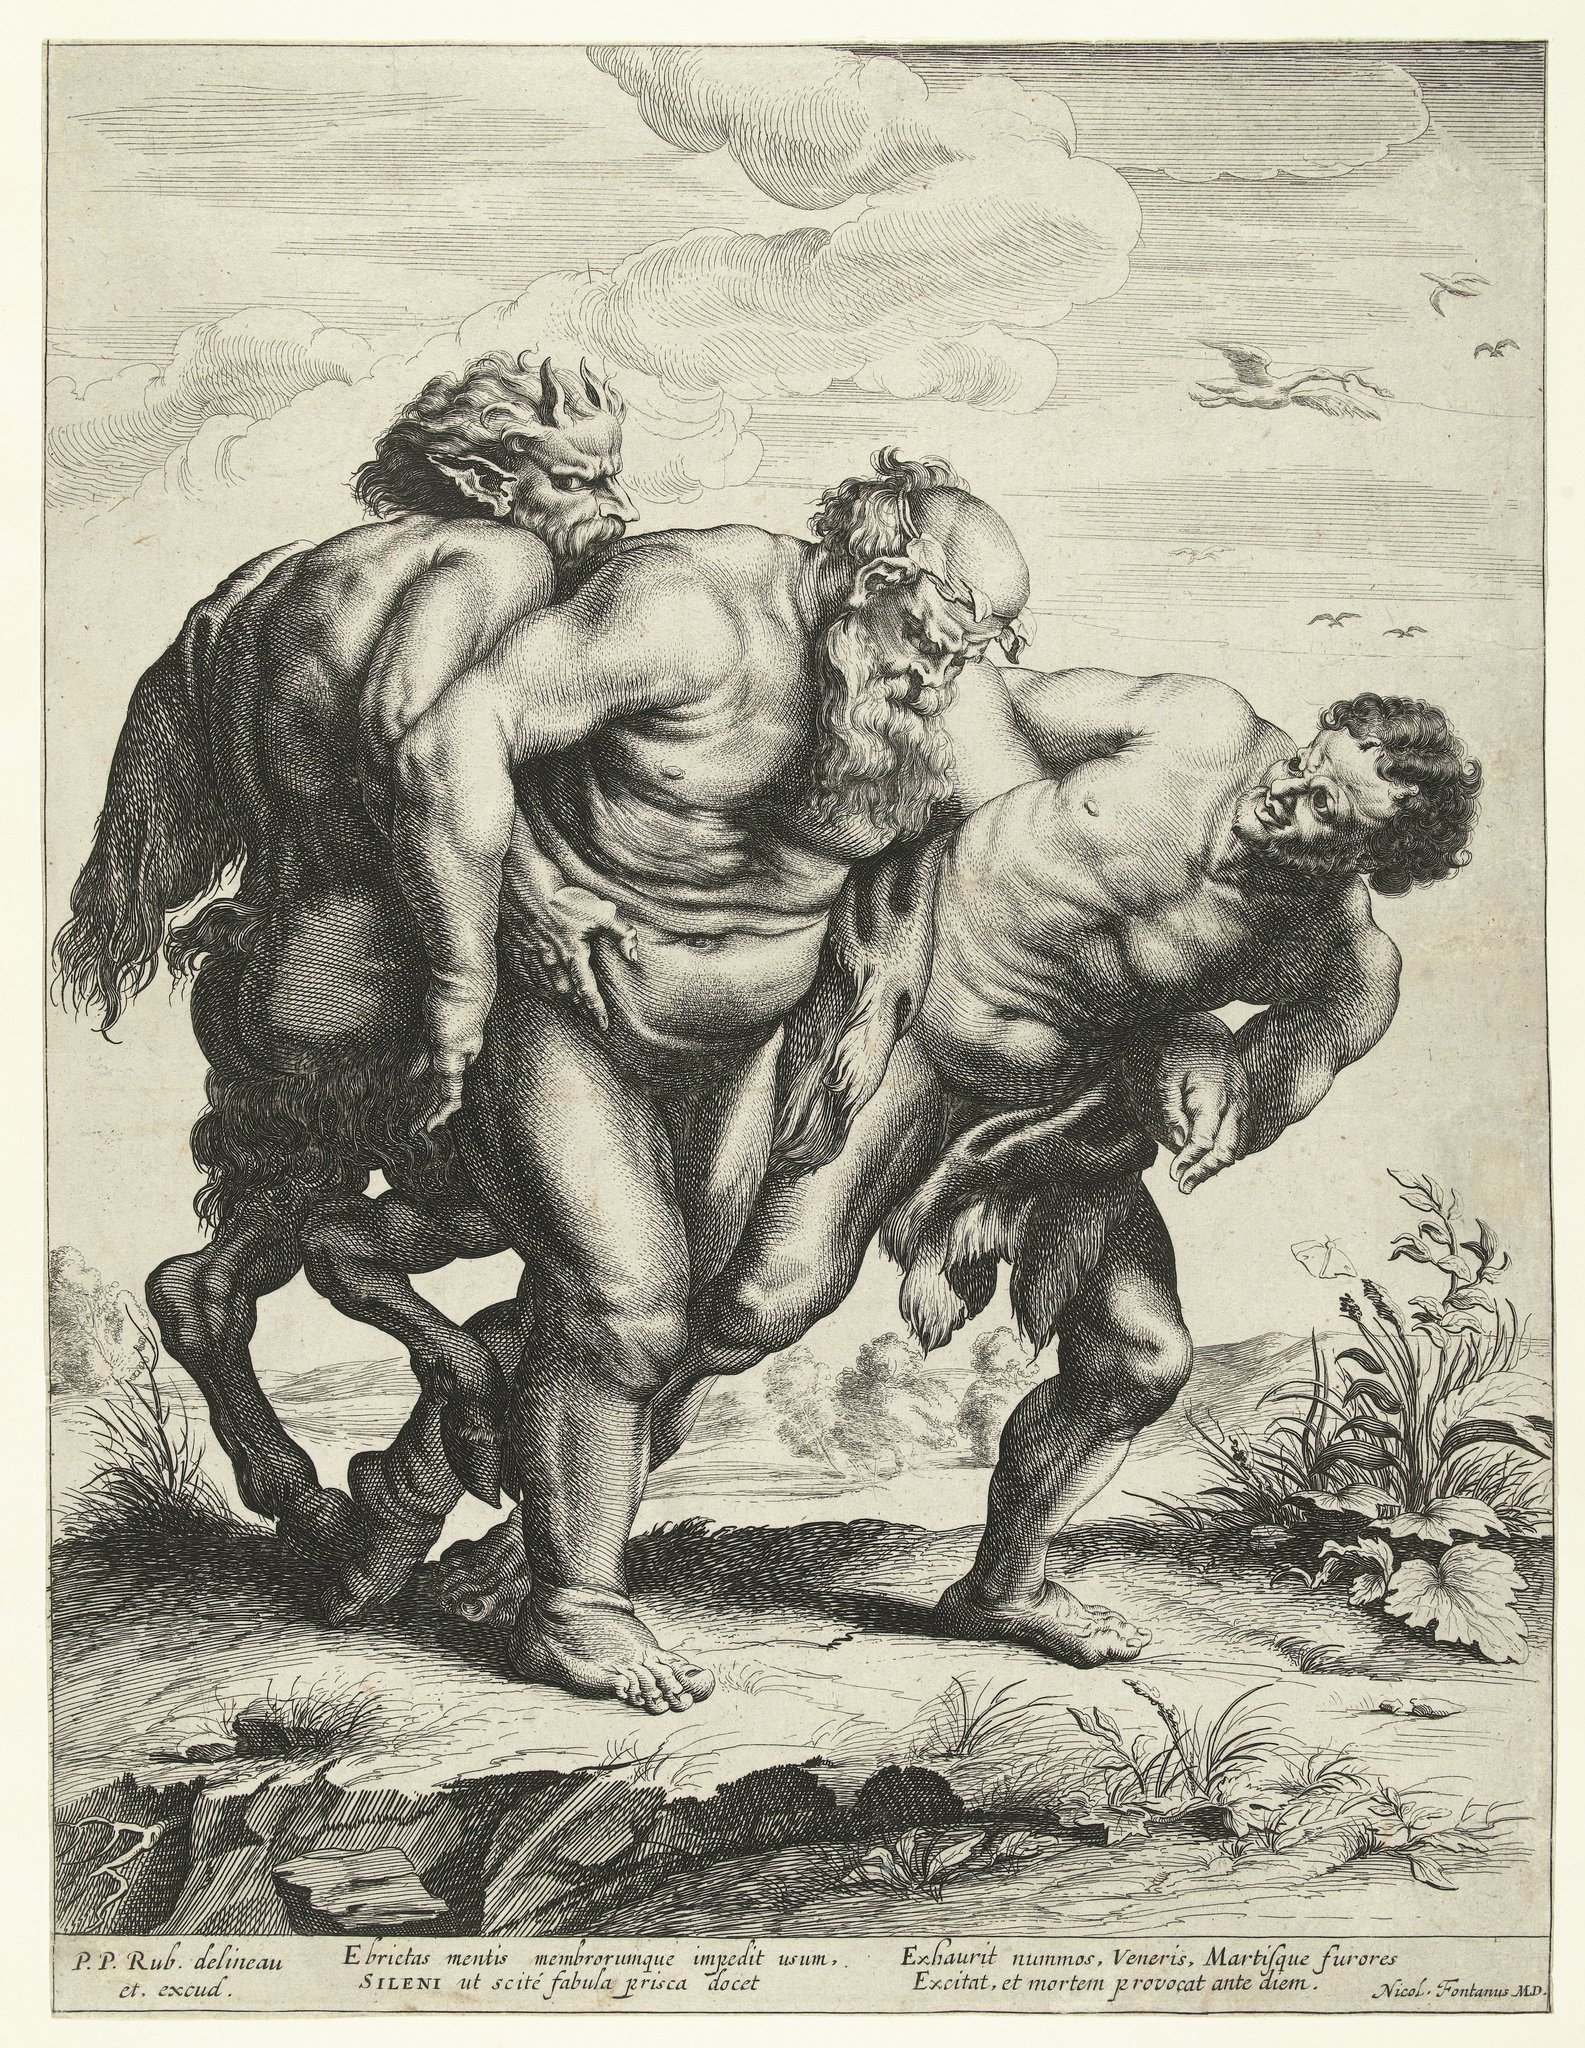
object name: print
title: Saters ondersteunen dronken Silenus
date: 1596-1659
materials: paper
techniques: engraving, etching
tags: (story of) silenus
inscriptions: collector's mark: Lugt 240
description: Twee saters ondersteunen de dronken Silenus. Onder de voorstelling staat een vers in Latijn.